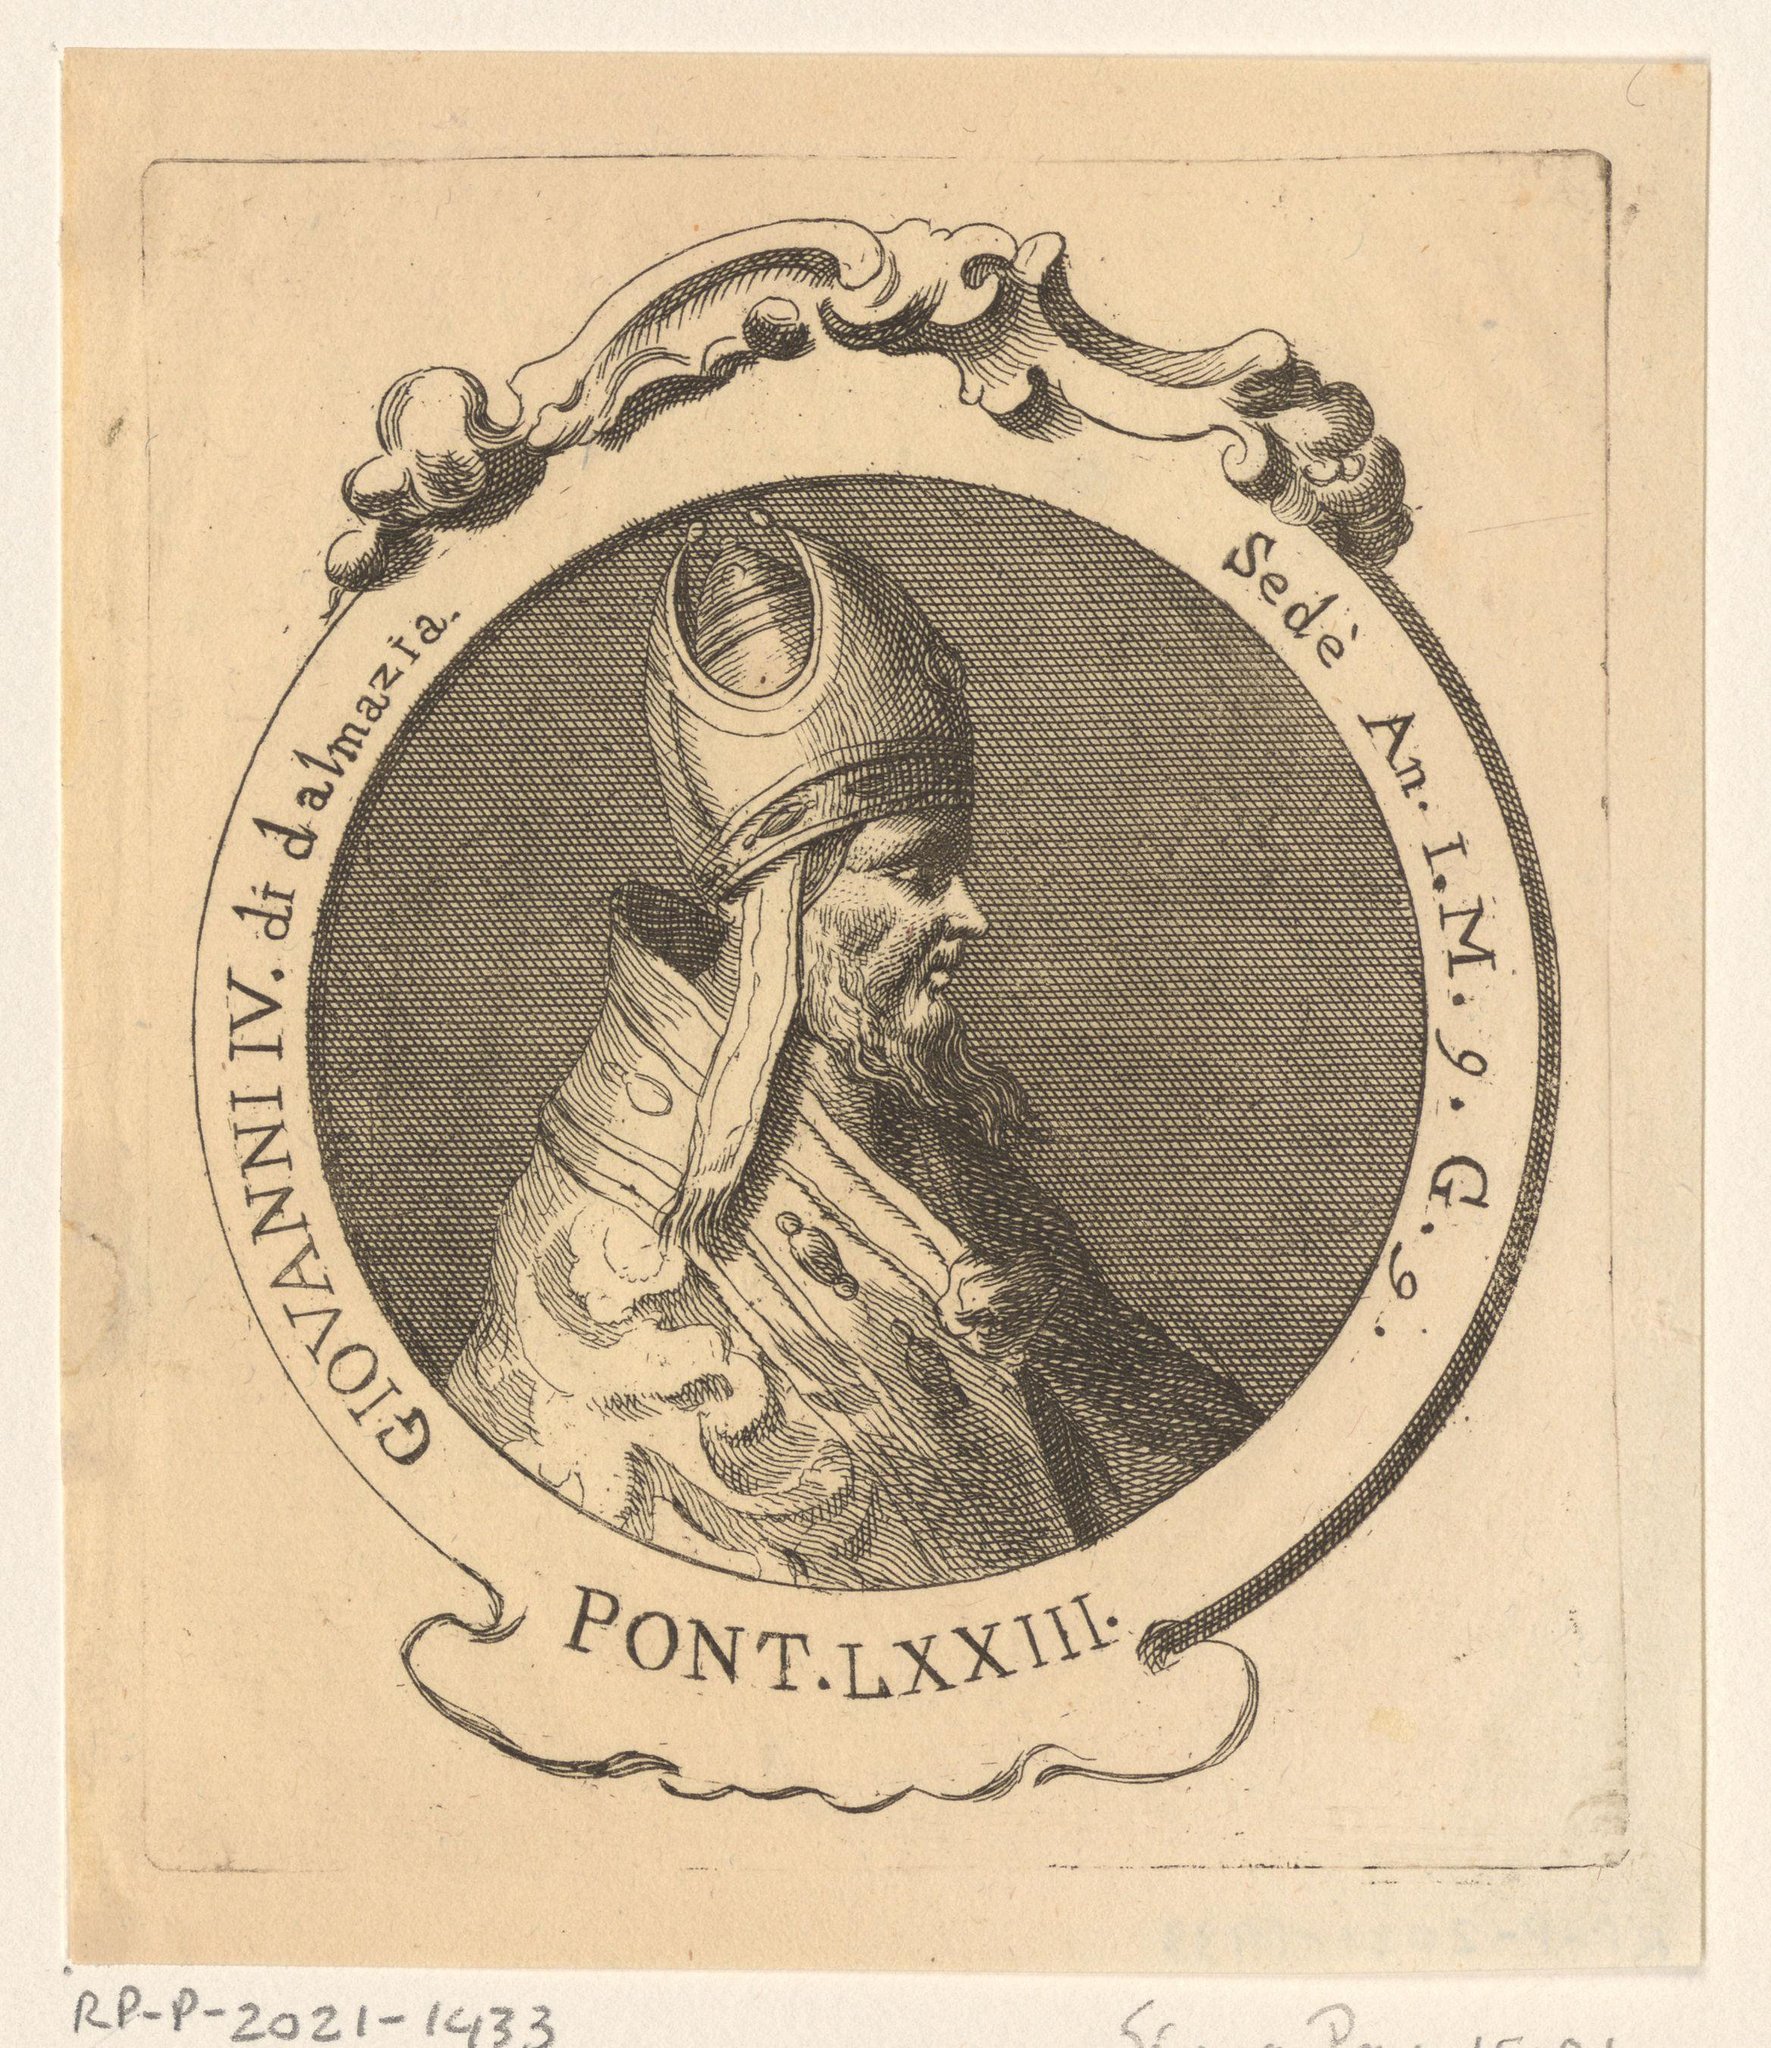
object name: print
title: Portret van paus Johannes IV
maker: Anonymous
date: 1761-1775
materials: paper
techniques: etching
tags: rome, historical persons, pope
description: Prent waarschijnlijk uit: Effigies Romanorum pontificum a S. Petro ad Pium VI (...). 2 dln. Venetië en Bassano del Grappa: Giuseppe Remondini, 1775. Prent met tekst op verso gebruikt in: Platina (Bartholomaeus Sacchi). Storia delle vite dei pontefici da Platina e d'altri autori (...). Venetië: Domenico Ferrarin, 1760, dl. 1, p. 309.